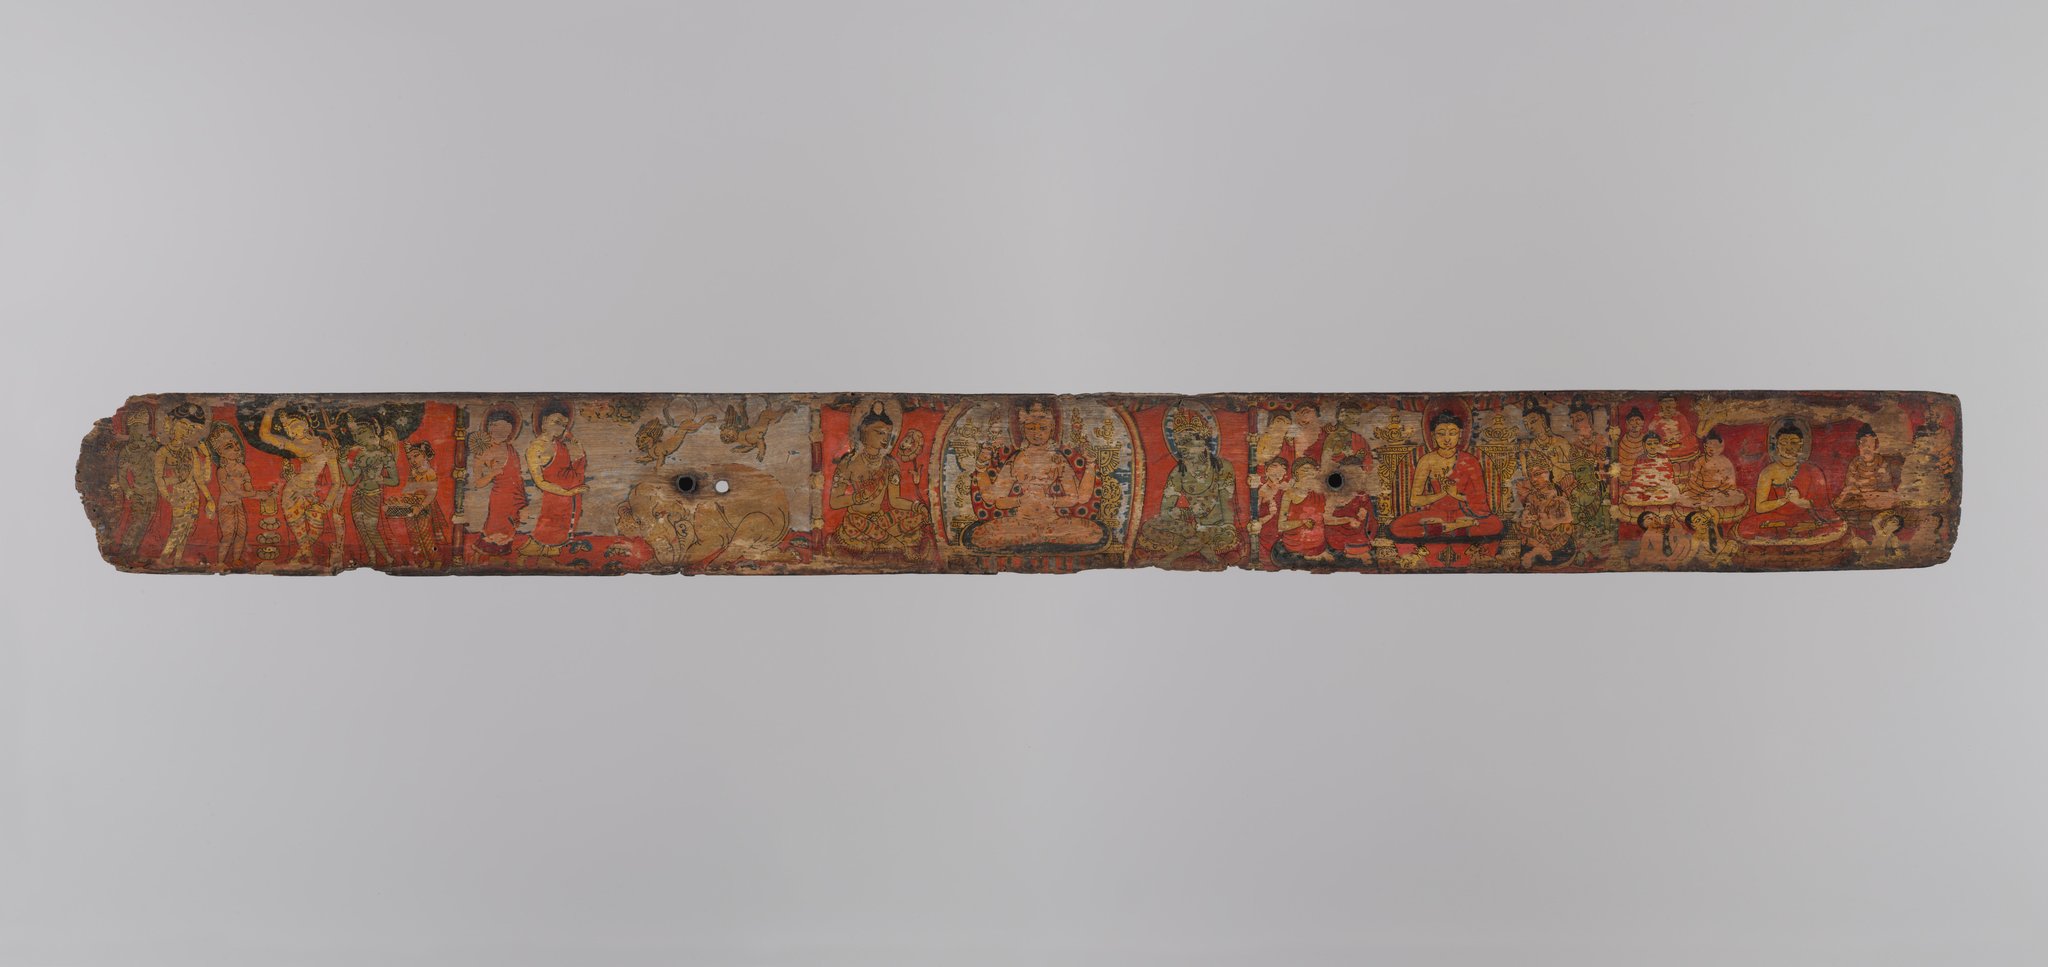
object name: book cover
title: Cover for an Ashtasahasrika Prajnaparamita Sutra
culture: nepali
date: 901-1100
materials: ink, metal, wood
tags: buddhism,bodhisattvas,buddha